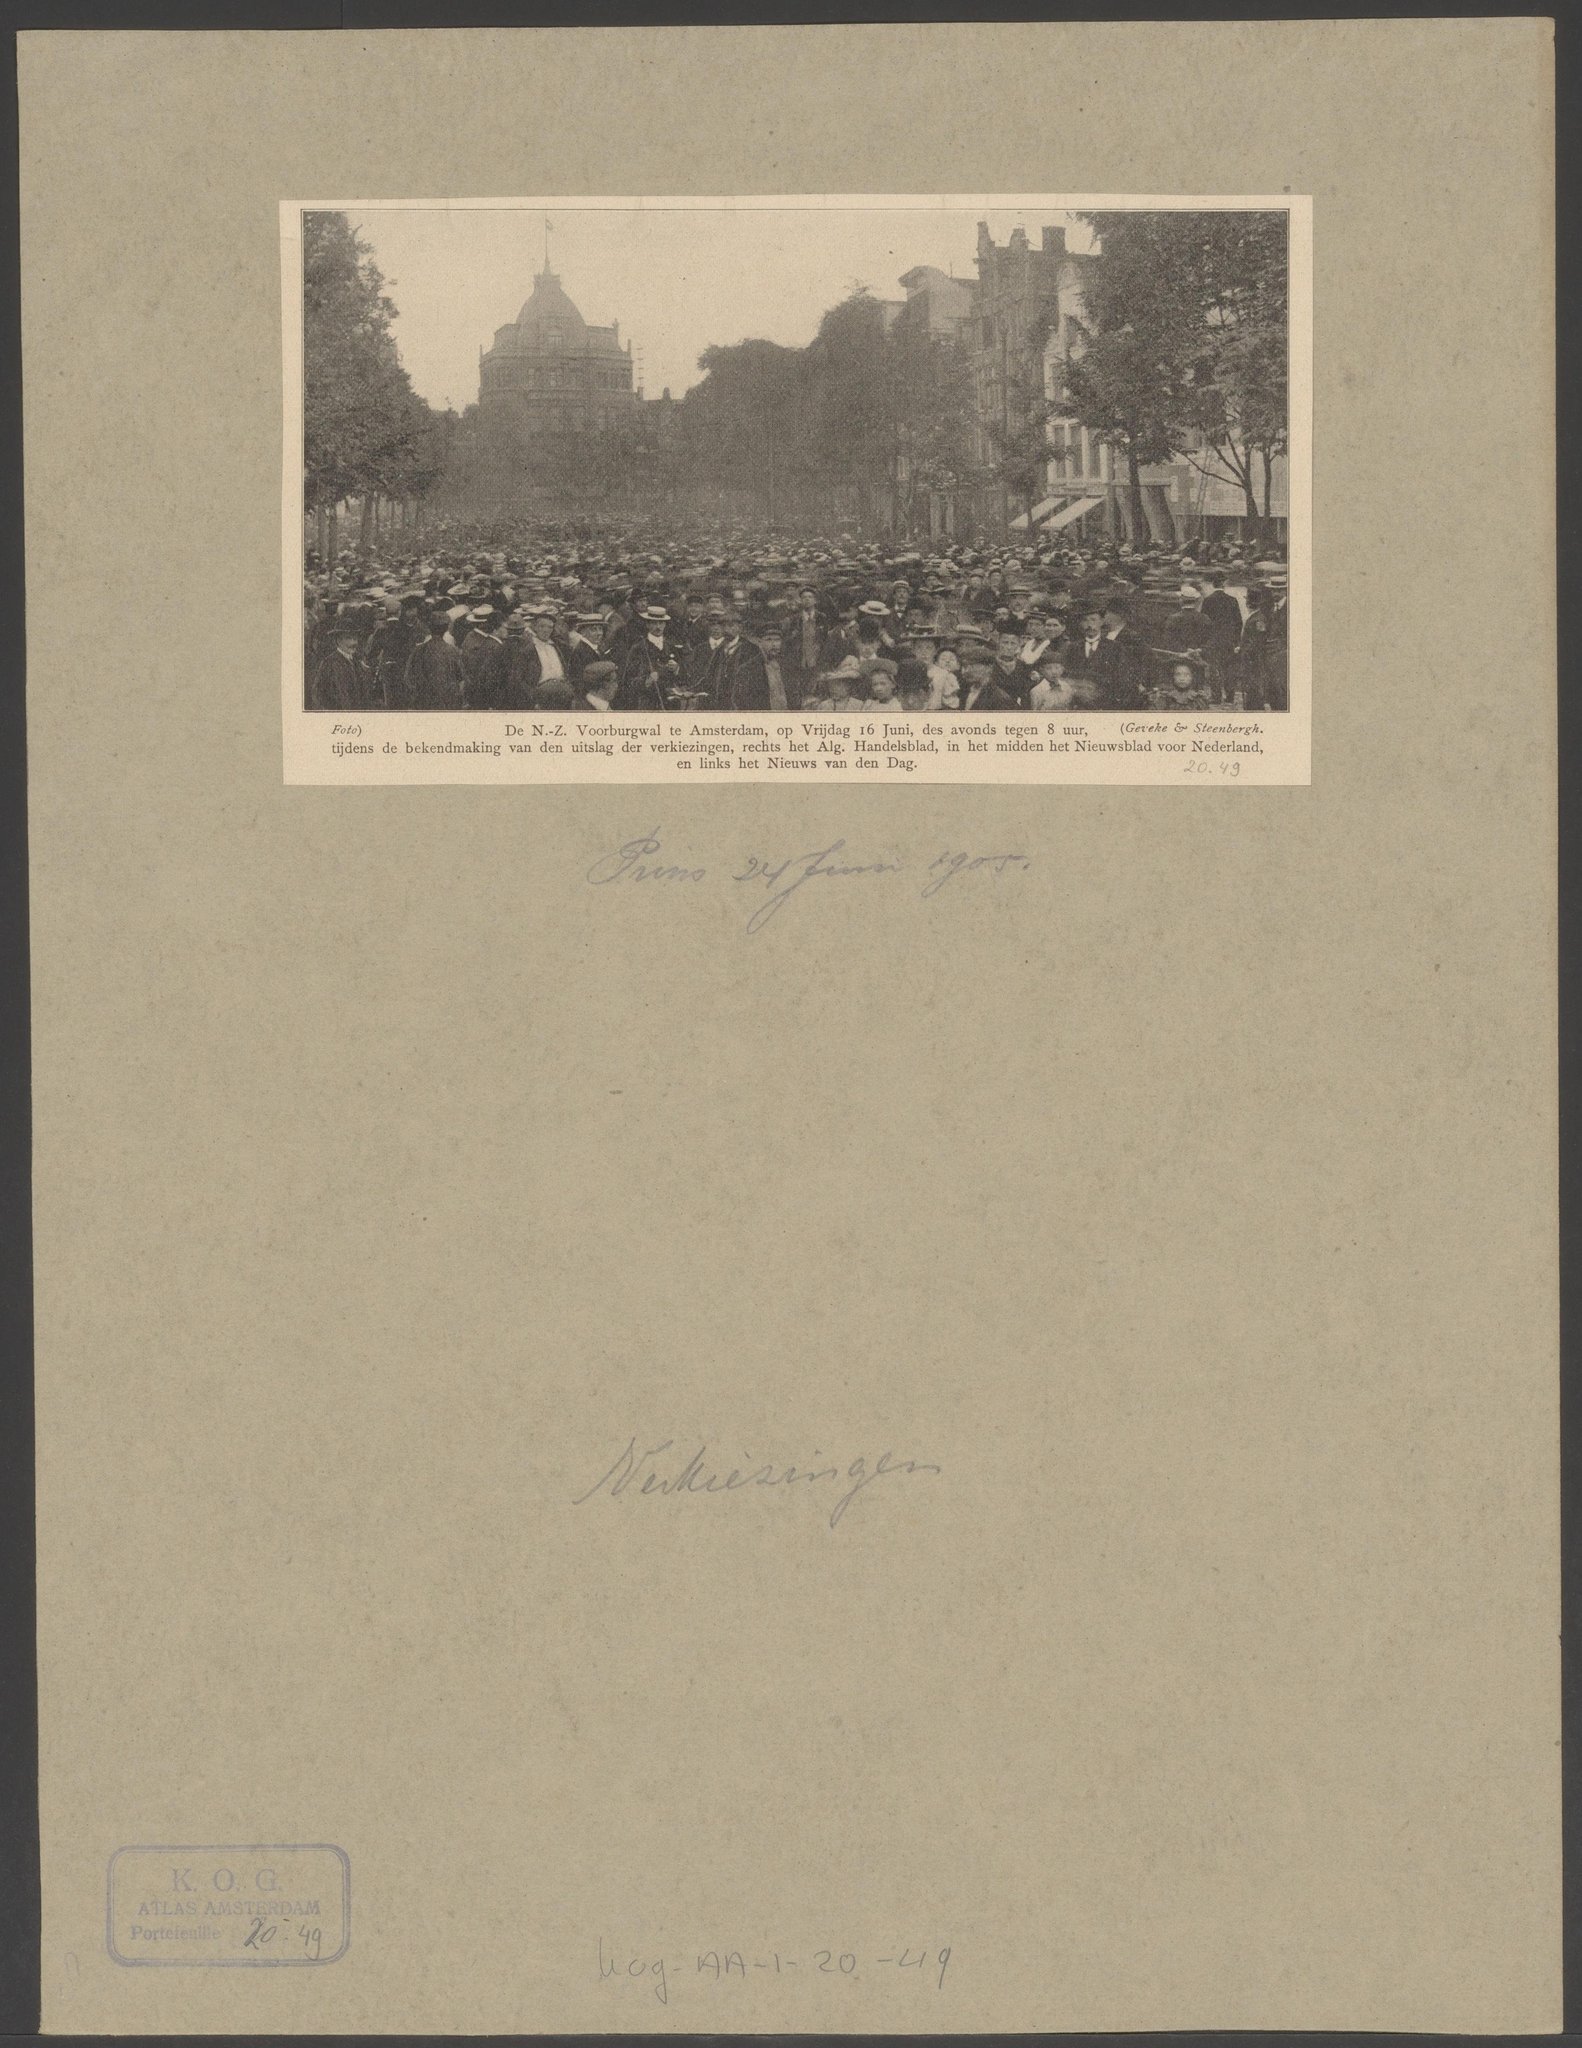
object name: photomechanical print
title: Mensenmassa tijdens de bekendmaking van de verkiezingsuitslag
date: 1905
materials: paper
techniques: letterpress printing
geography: amsterdam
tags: voting, election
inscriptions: collector's mark: Lugt 1641b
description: Onderwerpsrubriek binnen de Atlas Amsterdam: Verkiezingen Tweede Kamer.